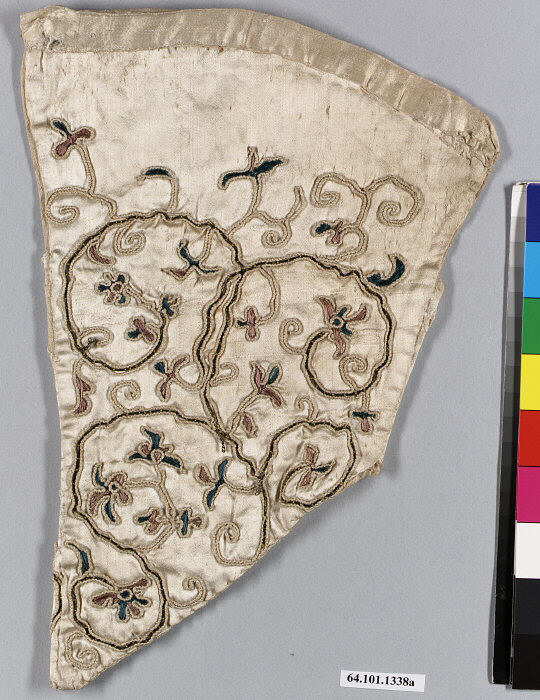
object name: dress sleeve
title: Pair of short dress sleeves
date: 1700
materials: metal thread, textile, silk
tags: flowers